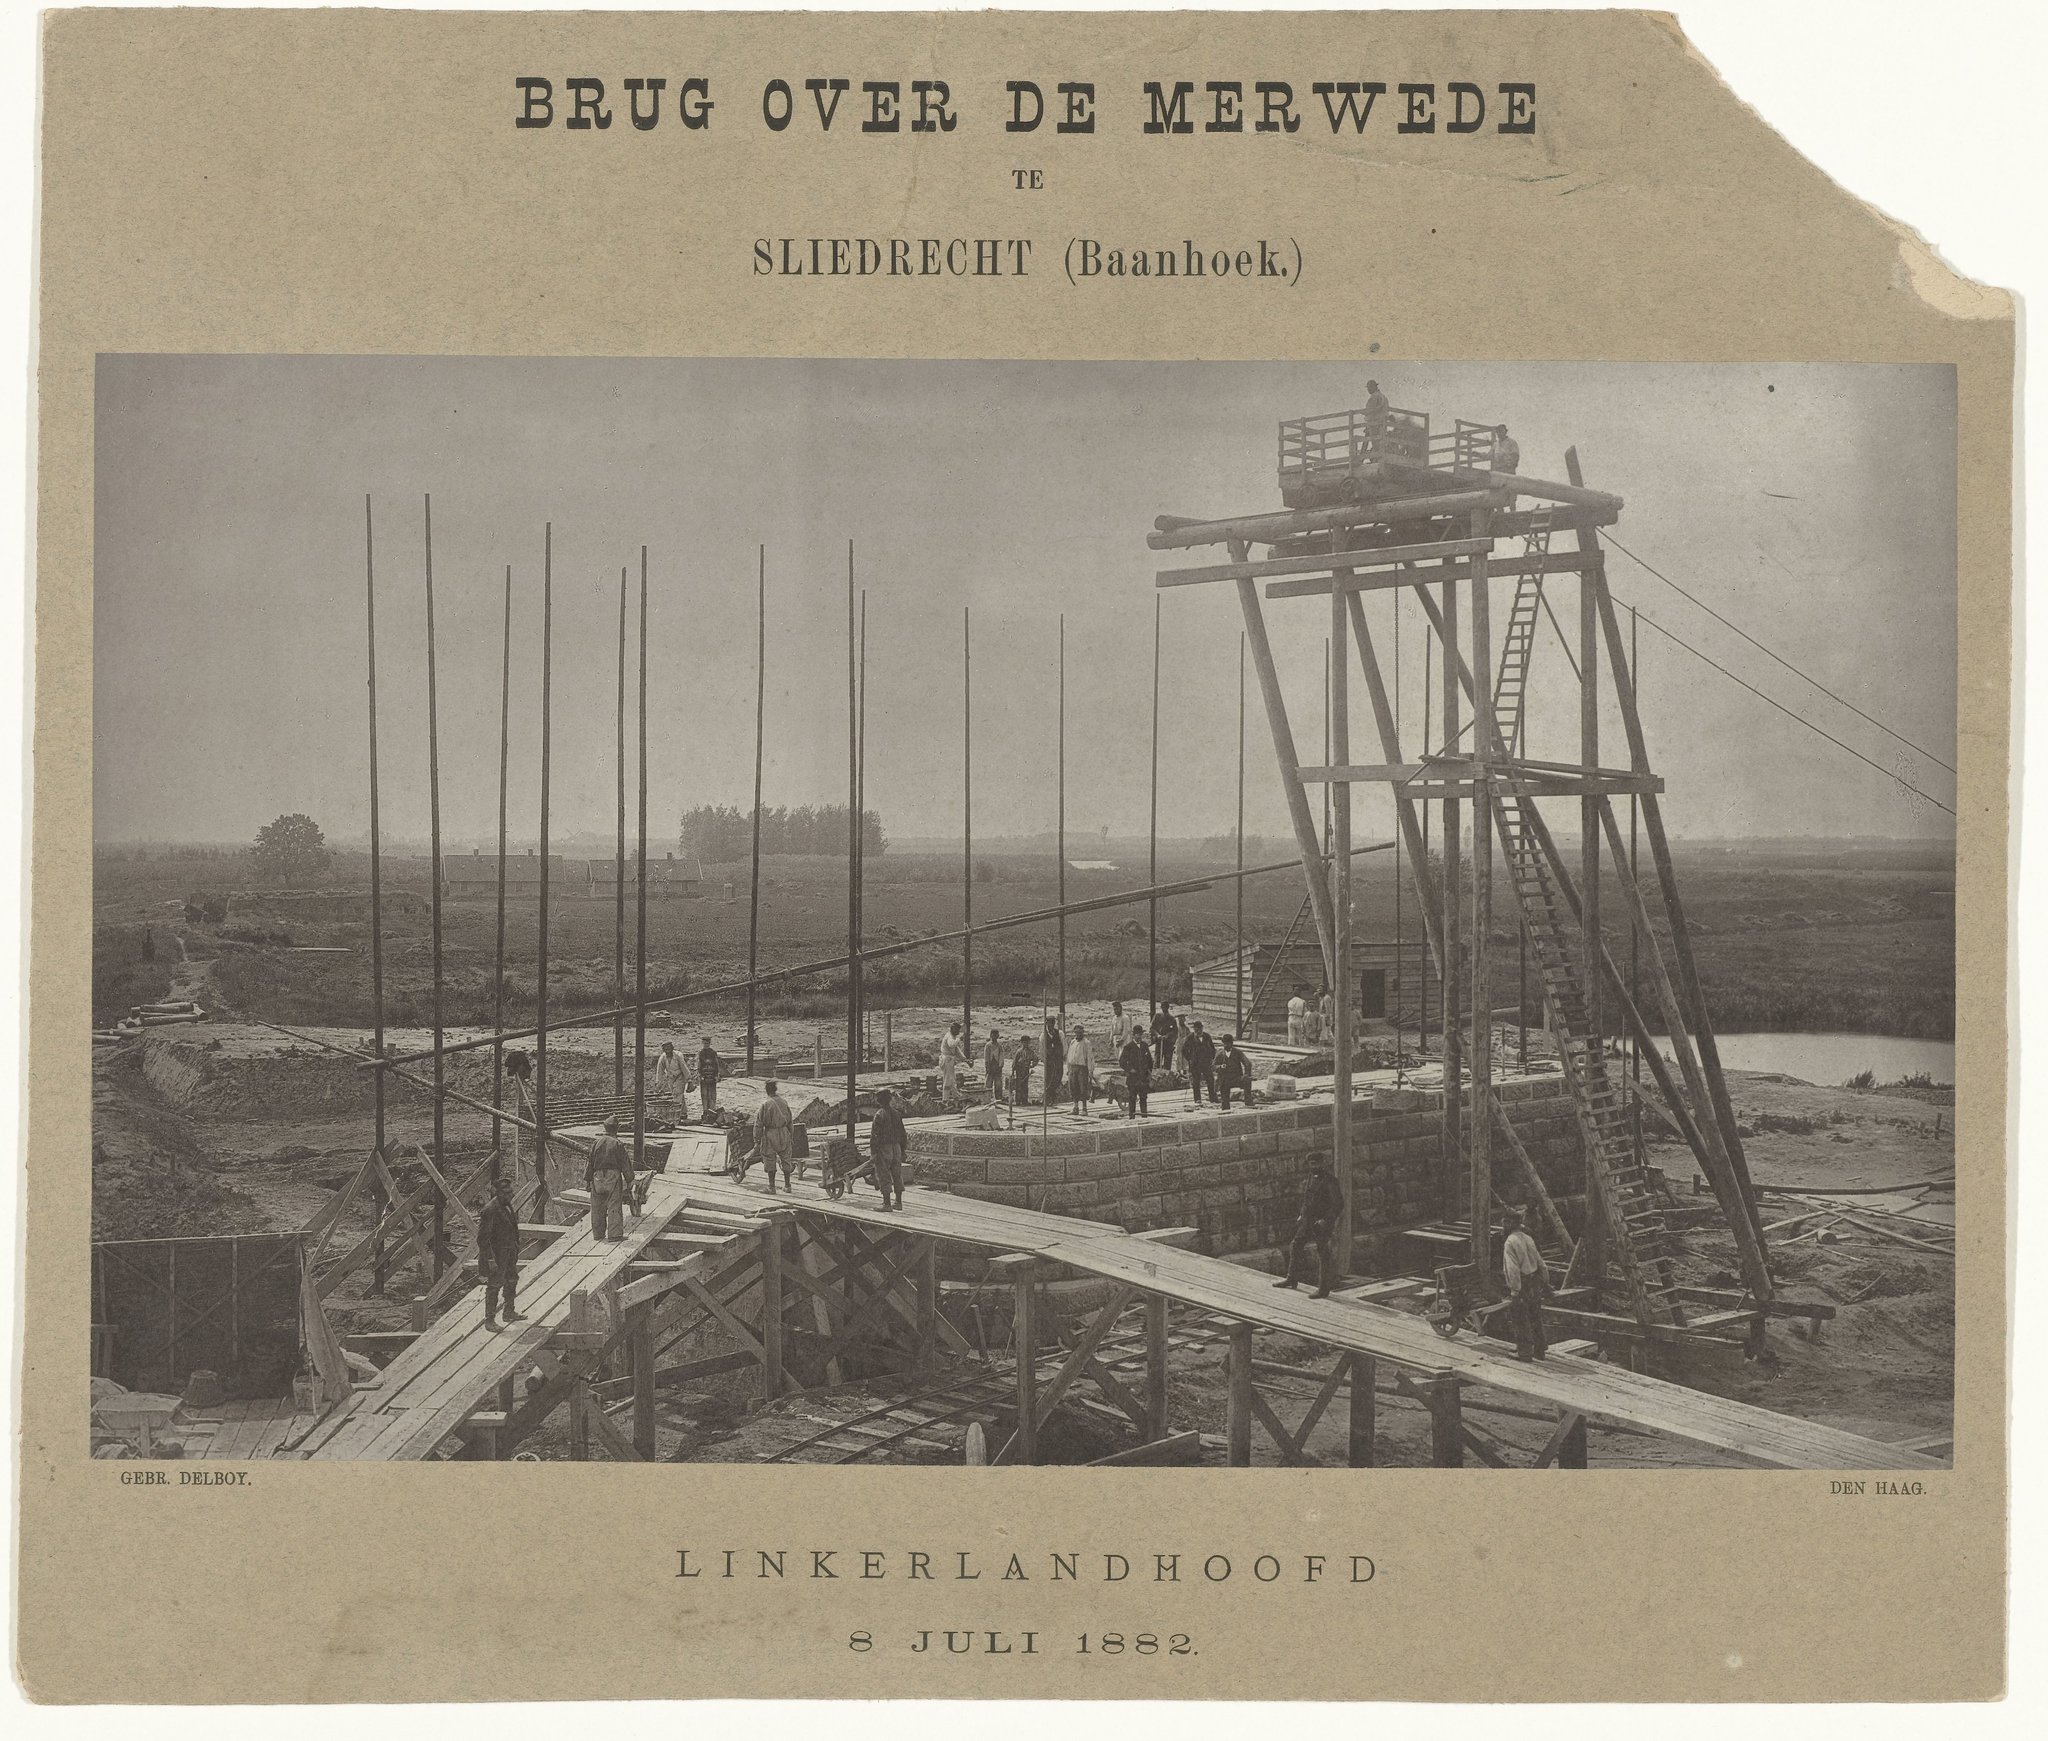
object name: photograph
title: Bouw van de brug over de Merwede bij Sliedrecht, Nederland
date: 1882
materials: cardboard, paper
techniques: photograph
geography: netherlands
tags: bridge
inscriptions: inscription: ‘BRUG OVER DE MERWEDE / TE / SLIEDRECHT (Baanhoek.) // GEBR. DELBOY. / DEN HAAG. // LINKERLANDHOOFD / 8 JULI 1882.’